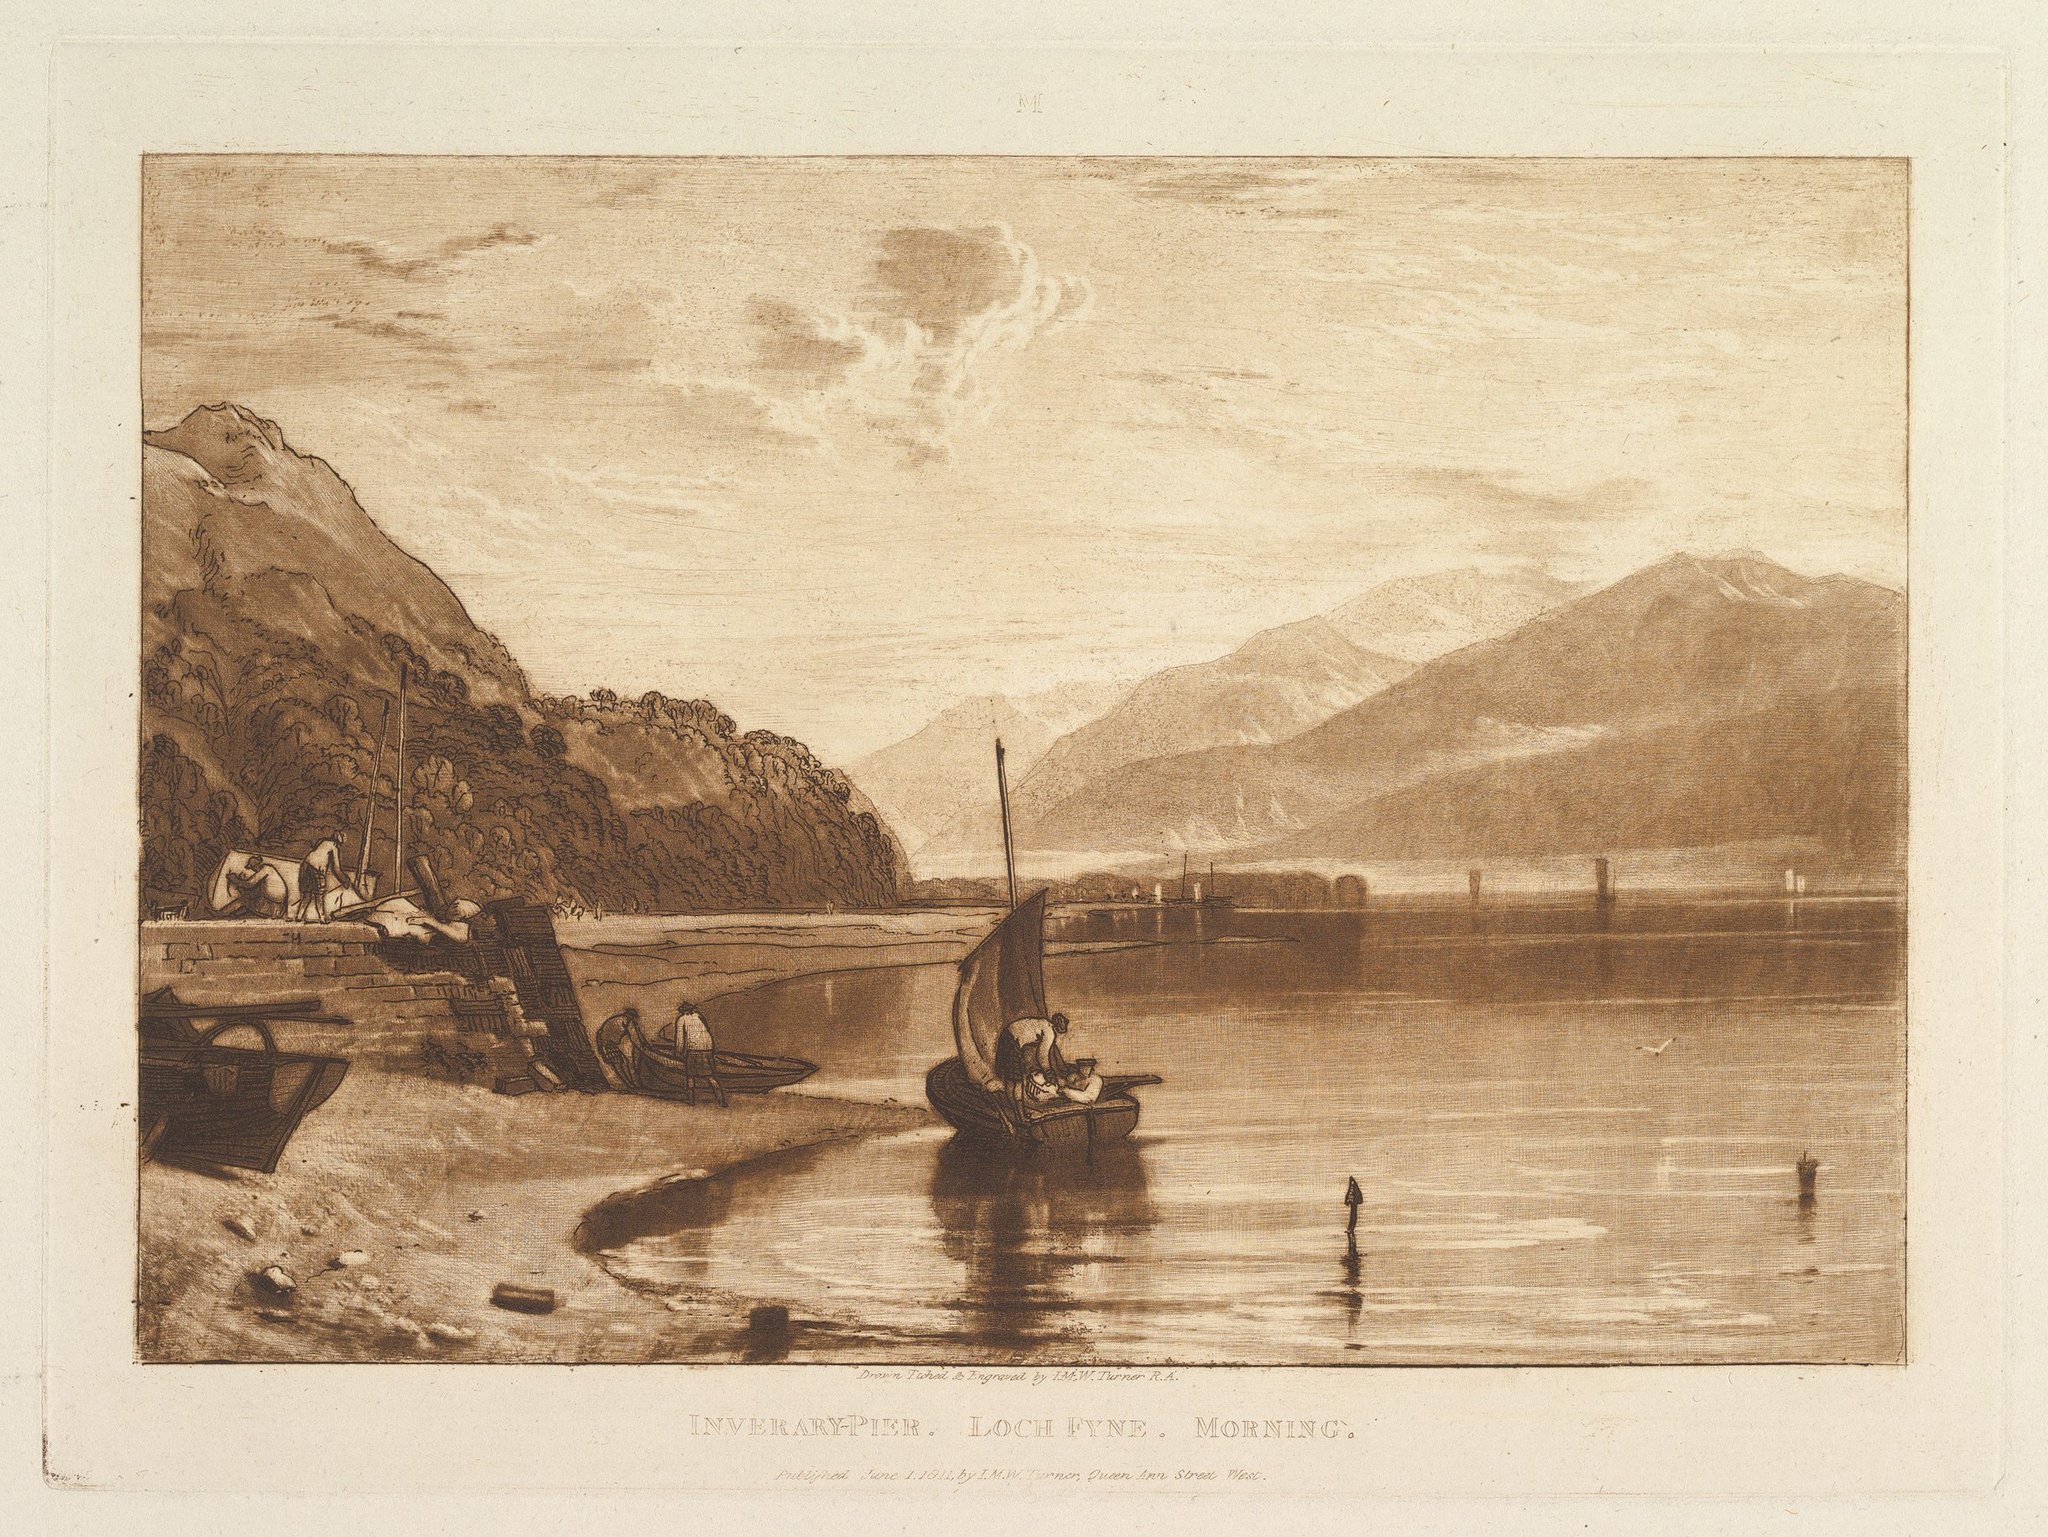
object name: print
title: Inverary Pier, Loch Fyne, Morning, part VII, plate 35 from "Liber Studiorum"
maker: joseph mallord william turner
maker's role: artist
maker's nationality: british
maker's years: 1775-1851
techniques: aquatint, etching, mezzotint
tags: human figures,mountains,landscapes,boats